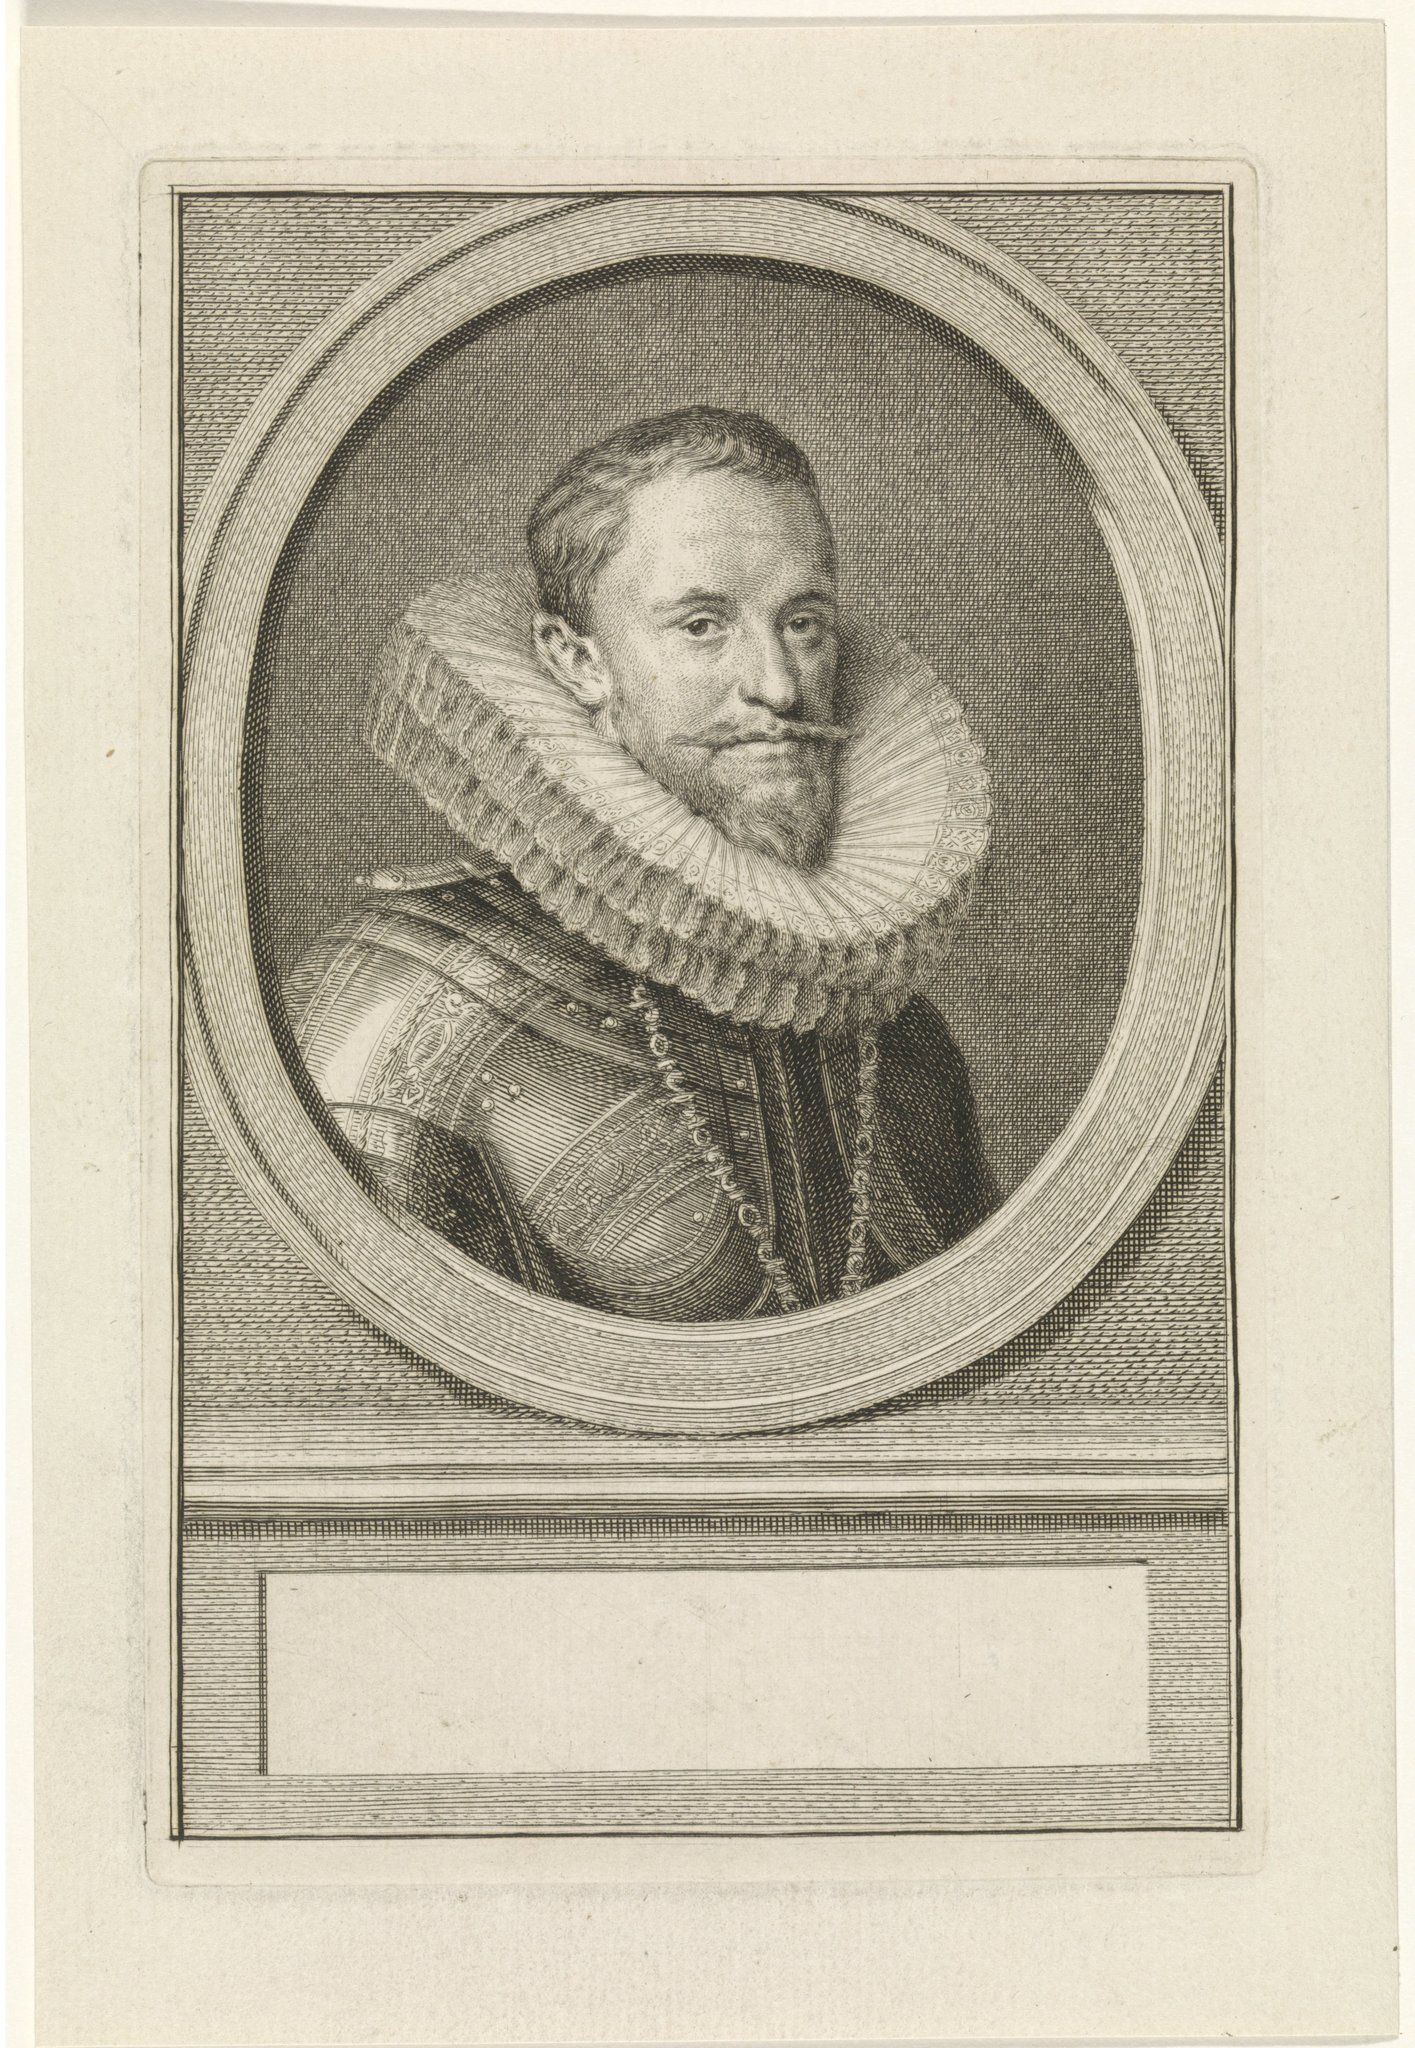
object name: print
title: Portret van Ambrogio Spinola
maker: jacob houbraken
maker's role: draughtsman, print maker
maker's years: 1698-1780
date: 1747-1759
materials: paper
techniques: engraving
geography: amsterdam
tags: castelnuovo scrivia, ambrogio spinola (markies de los balbases)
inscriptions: collector's mark: Lugt 240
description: Proefdruk van de prent gebruikt in: Jan Wagenaar, Vaderlandsche historie, vervattende de geschiedenissen der nu Vereenigde Nederlanden, inzonderheid die van Holland (...), 21 delen. Amsterdam, Johannes Allart, 1790-96.